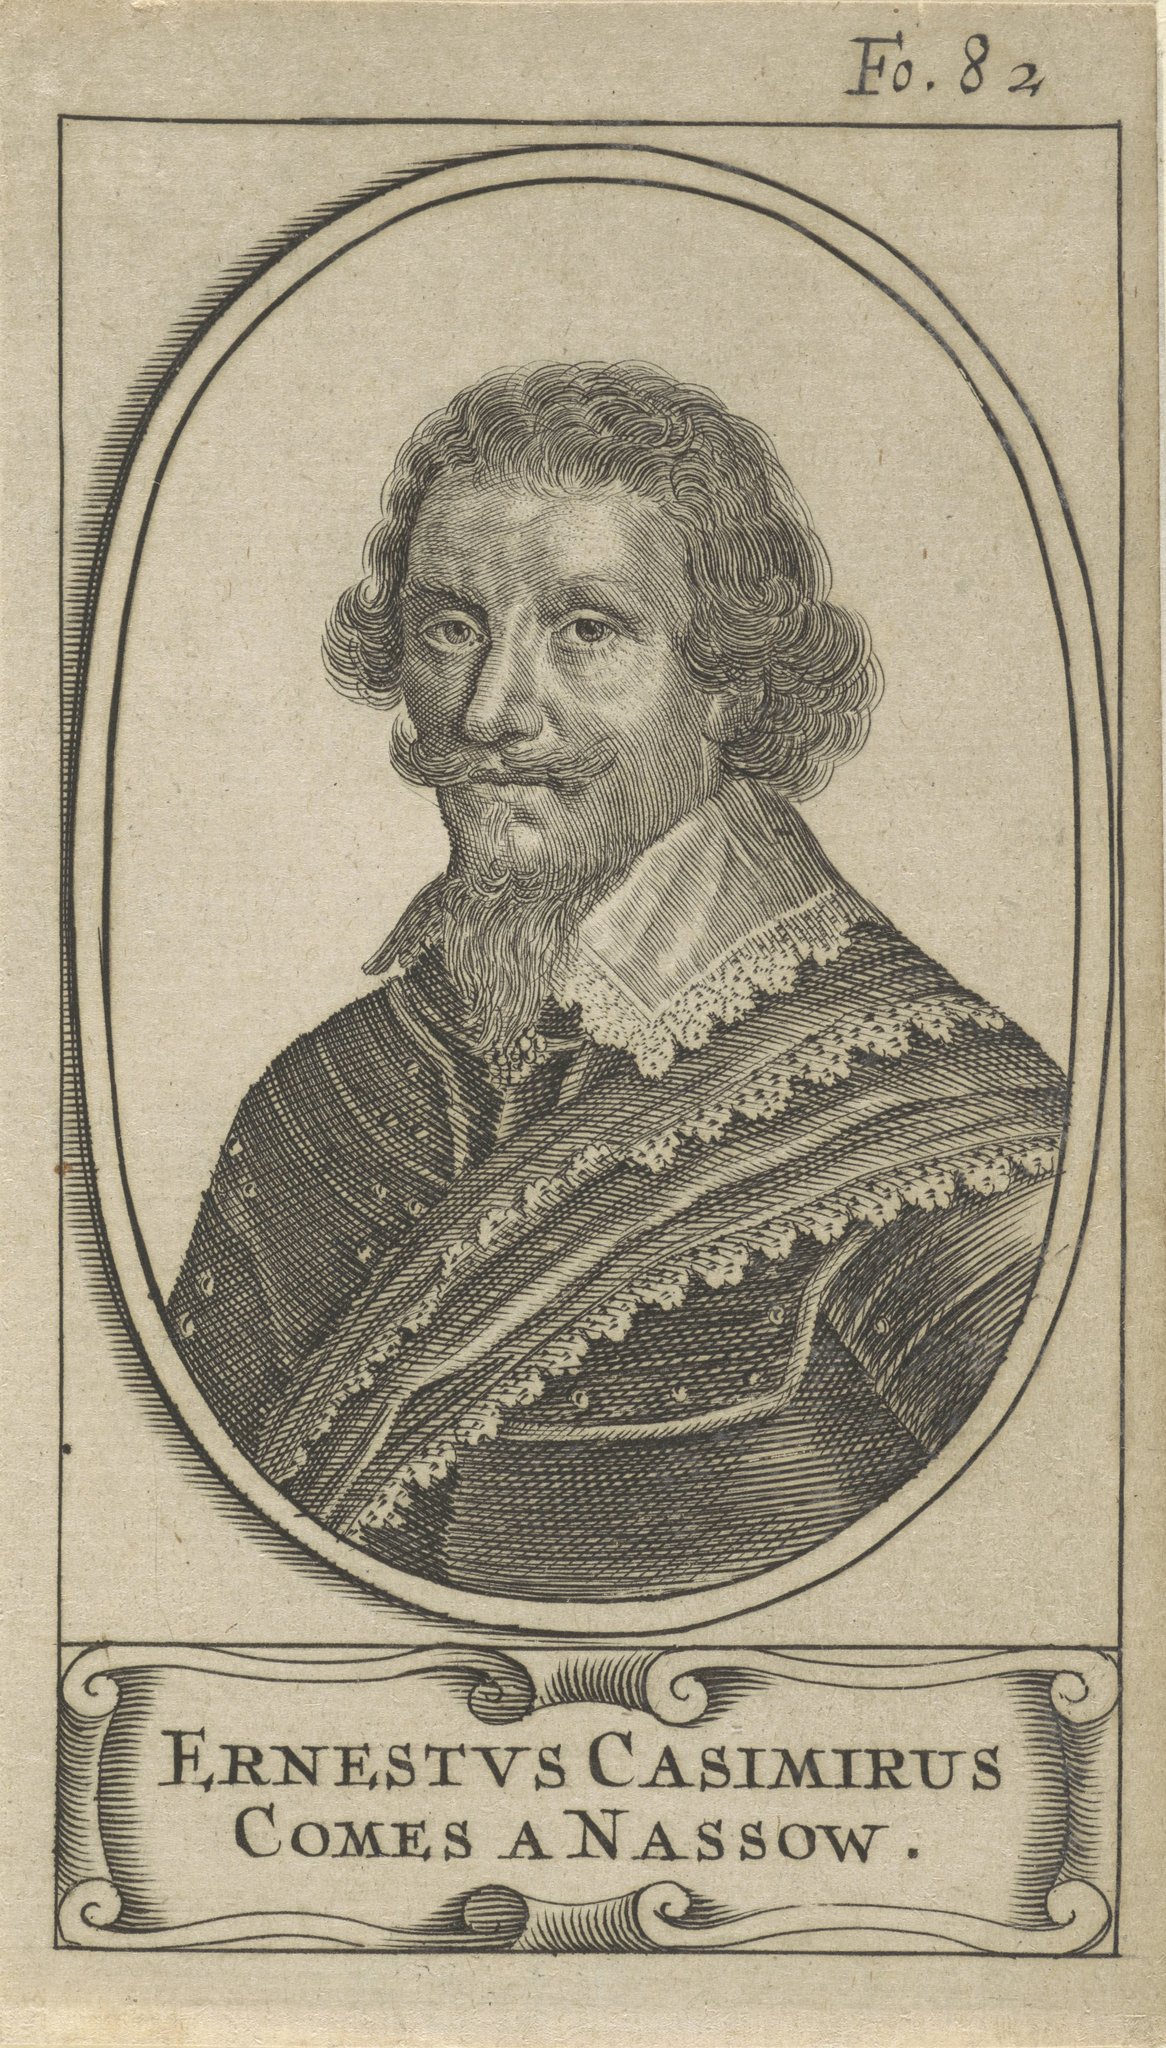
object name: print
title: Portret van Ernst Casimir, graaf van Nassau-Dietz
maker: Anonymous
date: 1600-1699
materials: paper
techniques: engraving, etching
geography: low countries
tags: ernst casimir graaf van nassau-dietz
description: De hier vermelde titel verwijst naar de hoogst verkregen titel van de geportretteerde, niet per se naar de titel die de geportretteerde op deze voorstelling draagt.